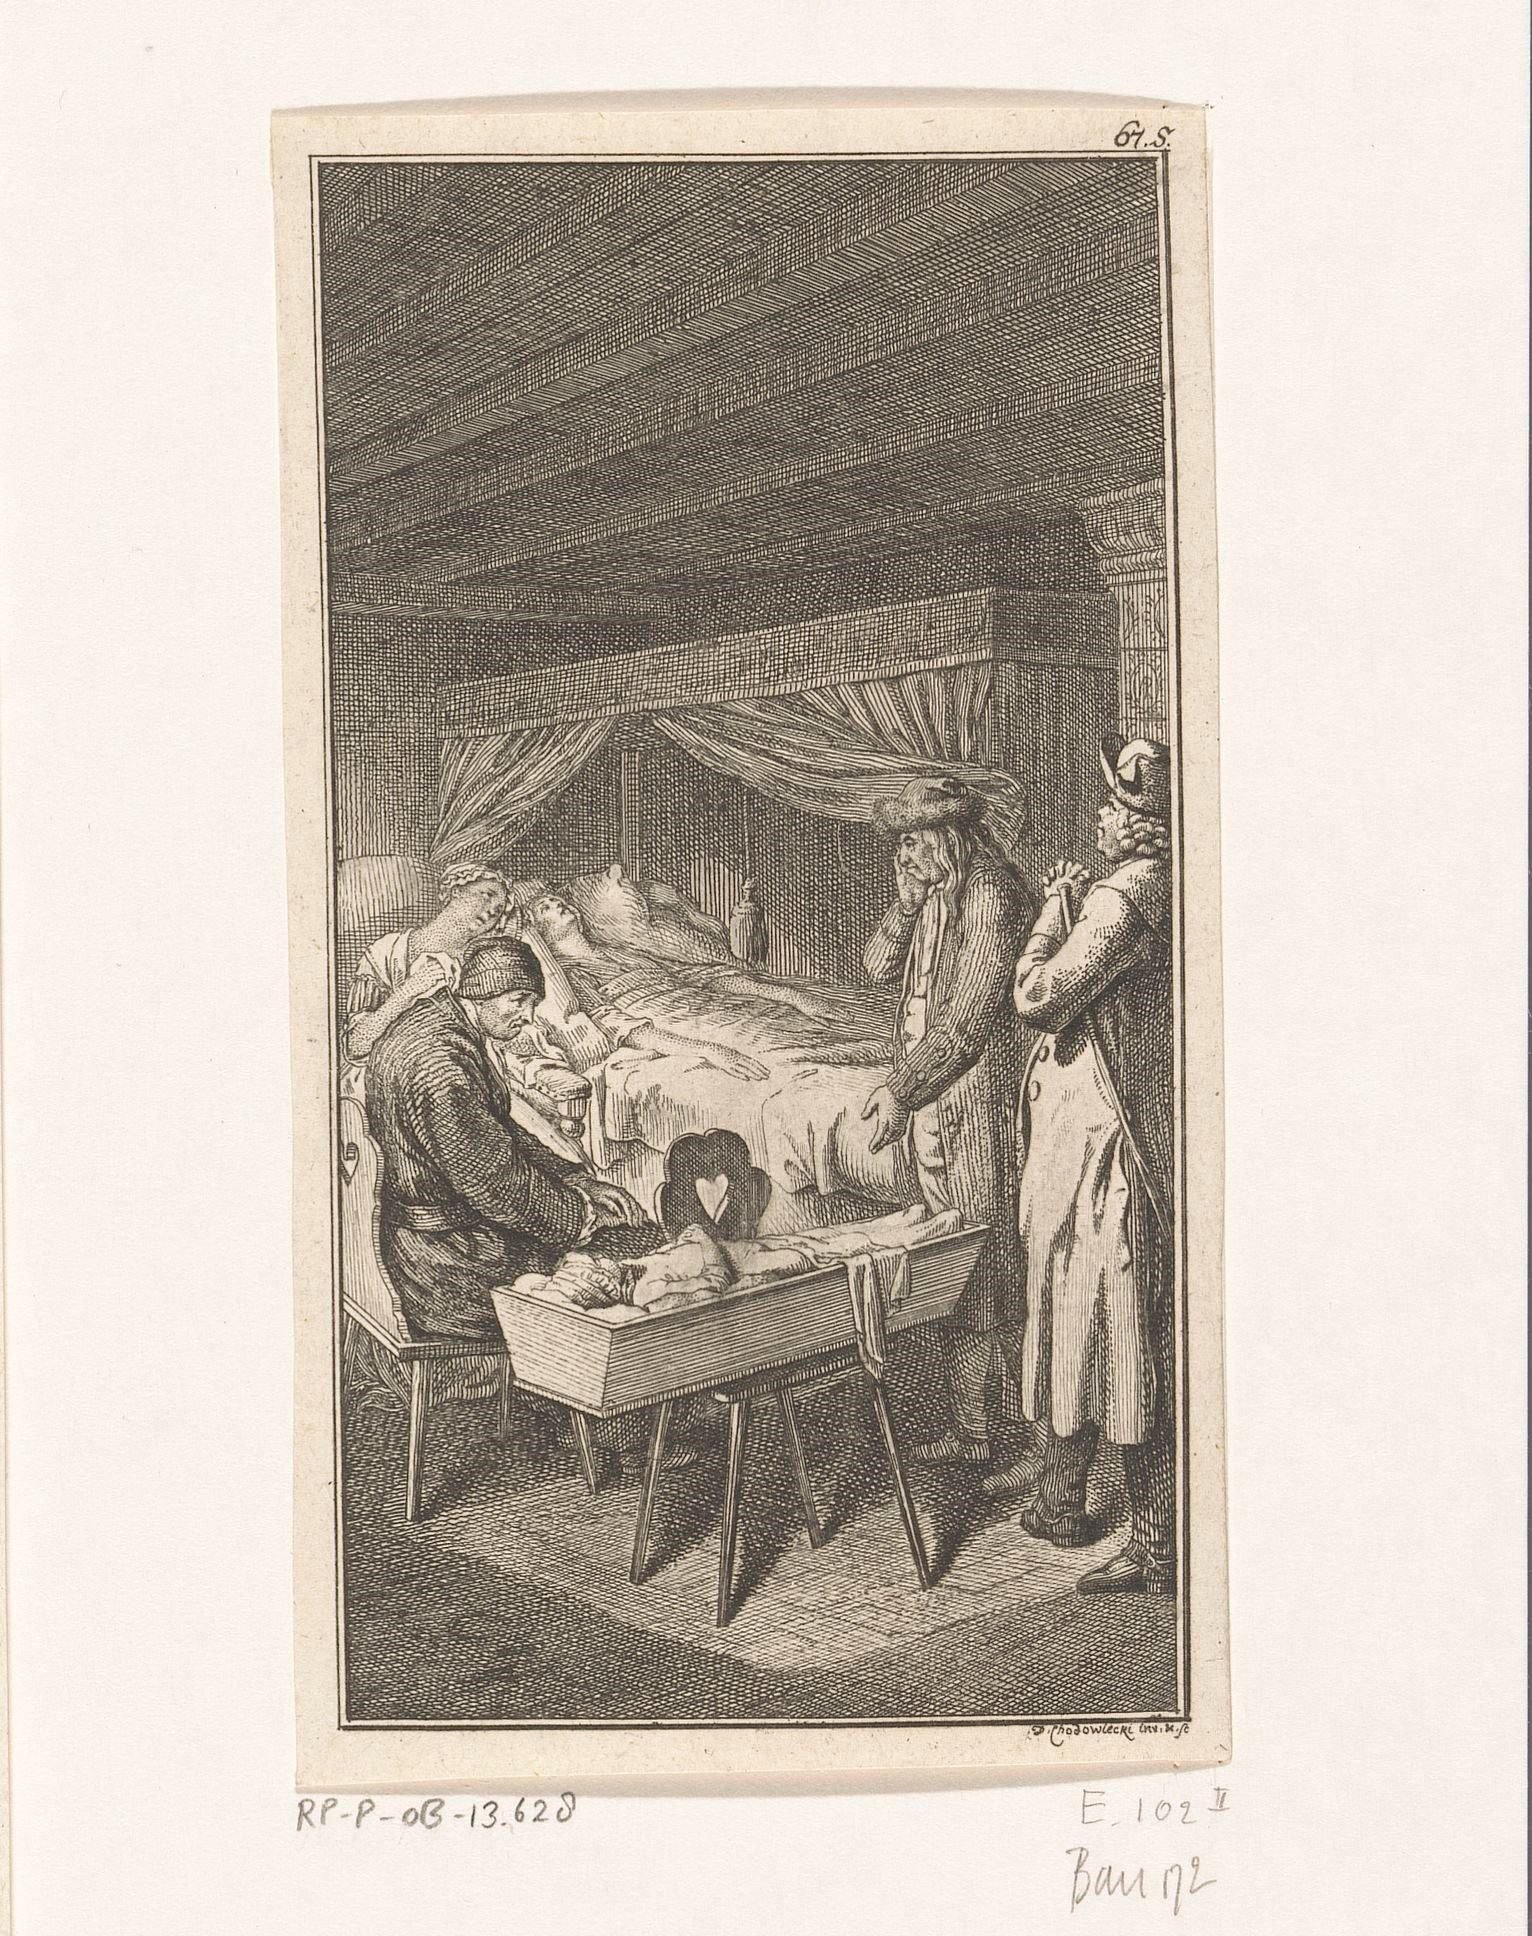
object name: print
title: Sebaldus Nothanker in rouw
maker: daniel nikolaus chodowiecki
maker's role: draughtsman, print maker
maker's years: 1726-1801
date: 1773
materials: paper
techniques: etching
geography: berlin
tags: berlin, publisher, friedrich nicolai, literature, deathbed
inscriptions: collector's mark: Lugt 2228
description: Deze scène behoort tot een serie prenten die het verhaal van Sebaldus Nothanker door Friedrich Nicolai illustreren. Voor een nieuwe editie van dit werk werd deze scène opnieuw in prent gebracht door Chodowiecki, waarschijnlijk vanwege slijtage aan de eerder gebruikte plaat (vergelijk RP-P-OB-13.621). De tweede staat van deze prent is gebruikt in: [Nicolai Friedrich]. Das Leben und die Meinungen des Herrn Magister Sebaldus Nothanker. Berlijn en Stettin: Friedrich Nicolai, 1776 [derde editie], dl. 1.